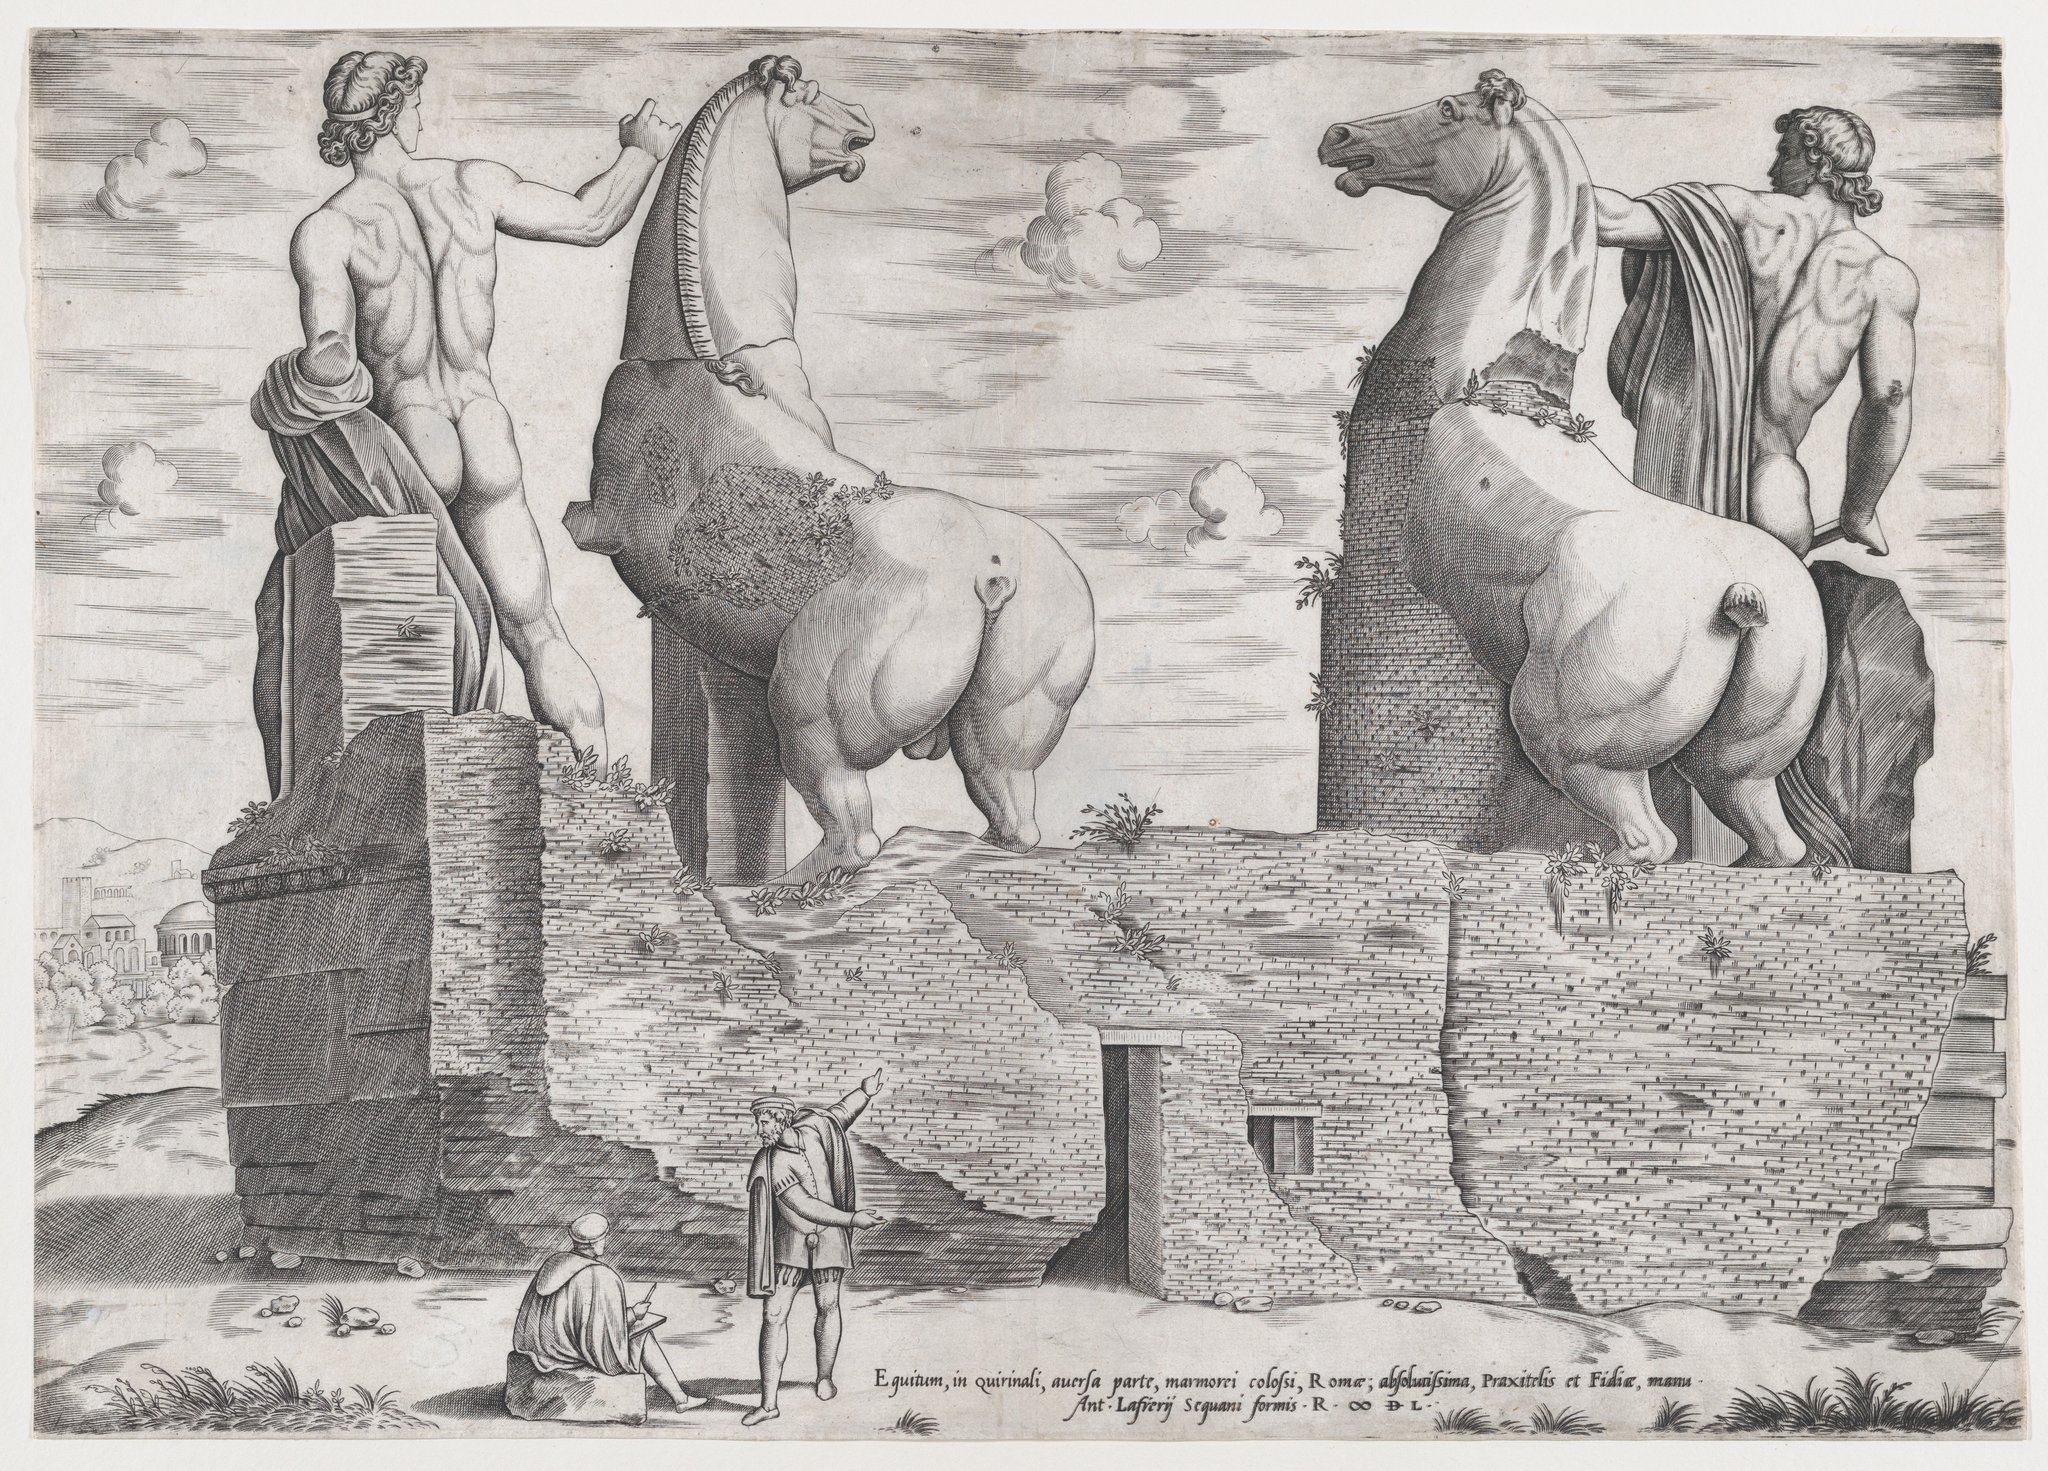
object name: print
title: View of the Back of Statues of the Dioscuri at the Quirinal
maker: Anonymous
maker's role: artist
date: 1550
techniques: engraving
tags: men,male nudes,horses,rome